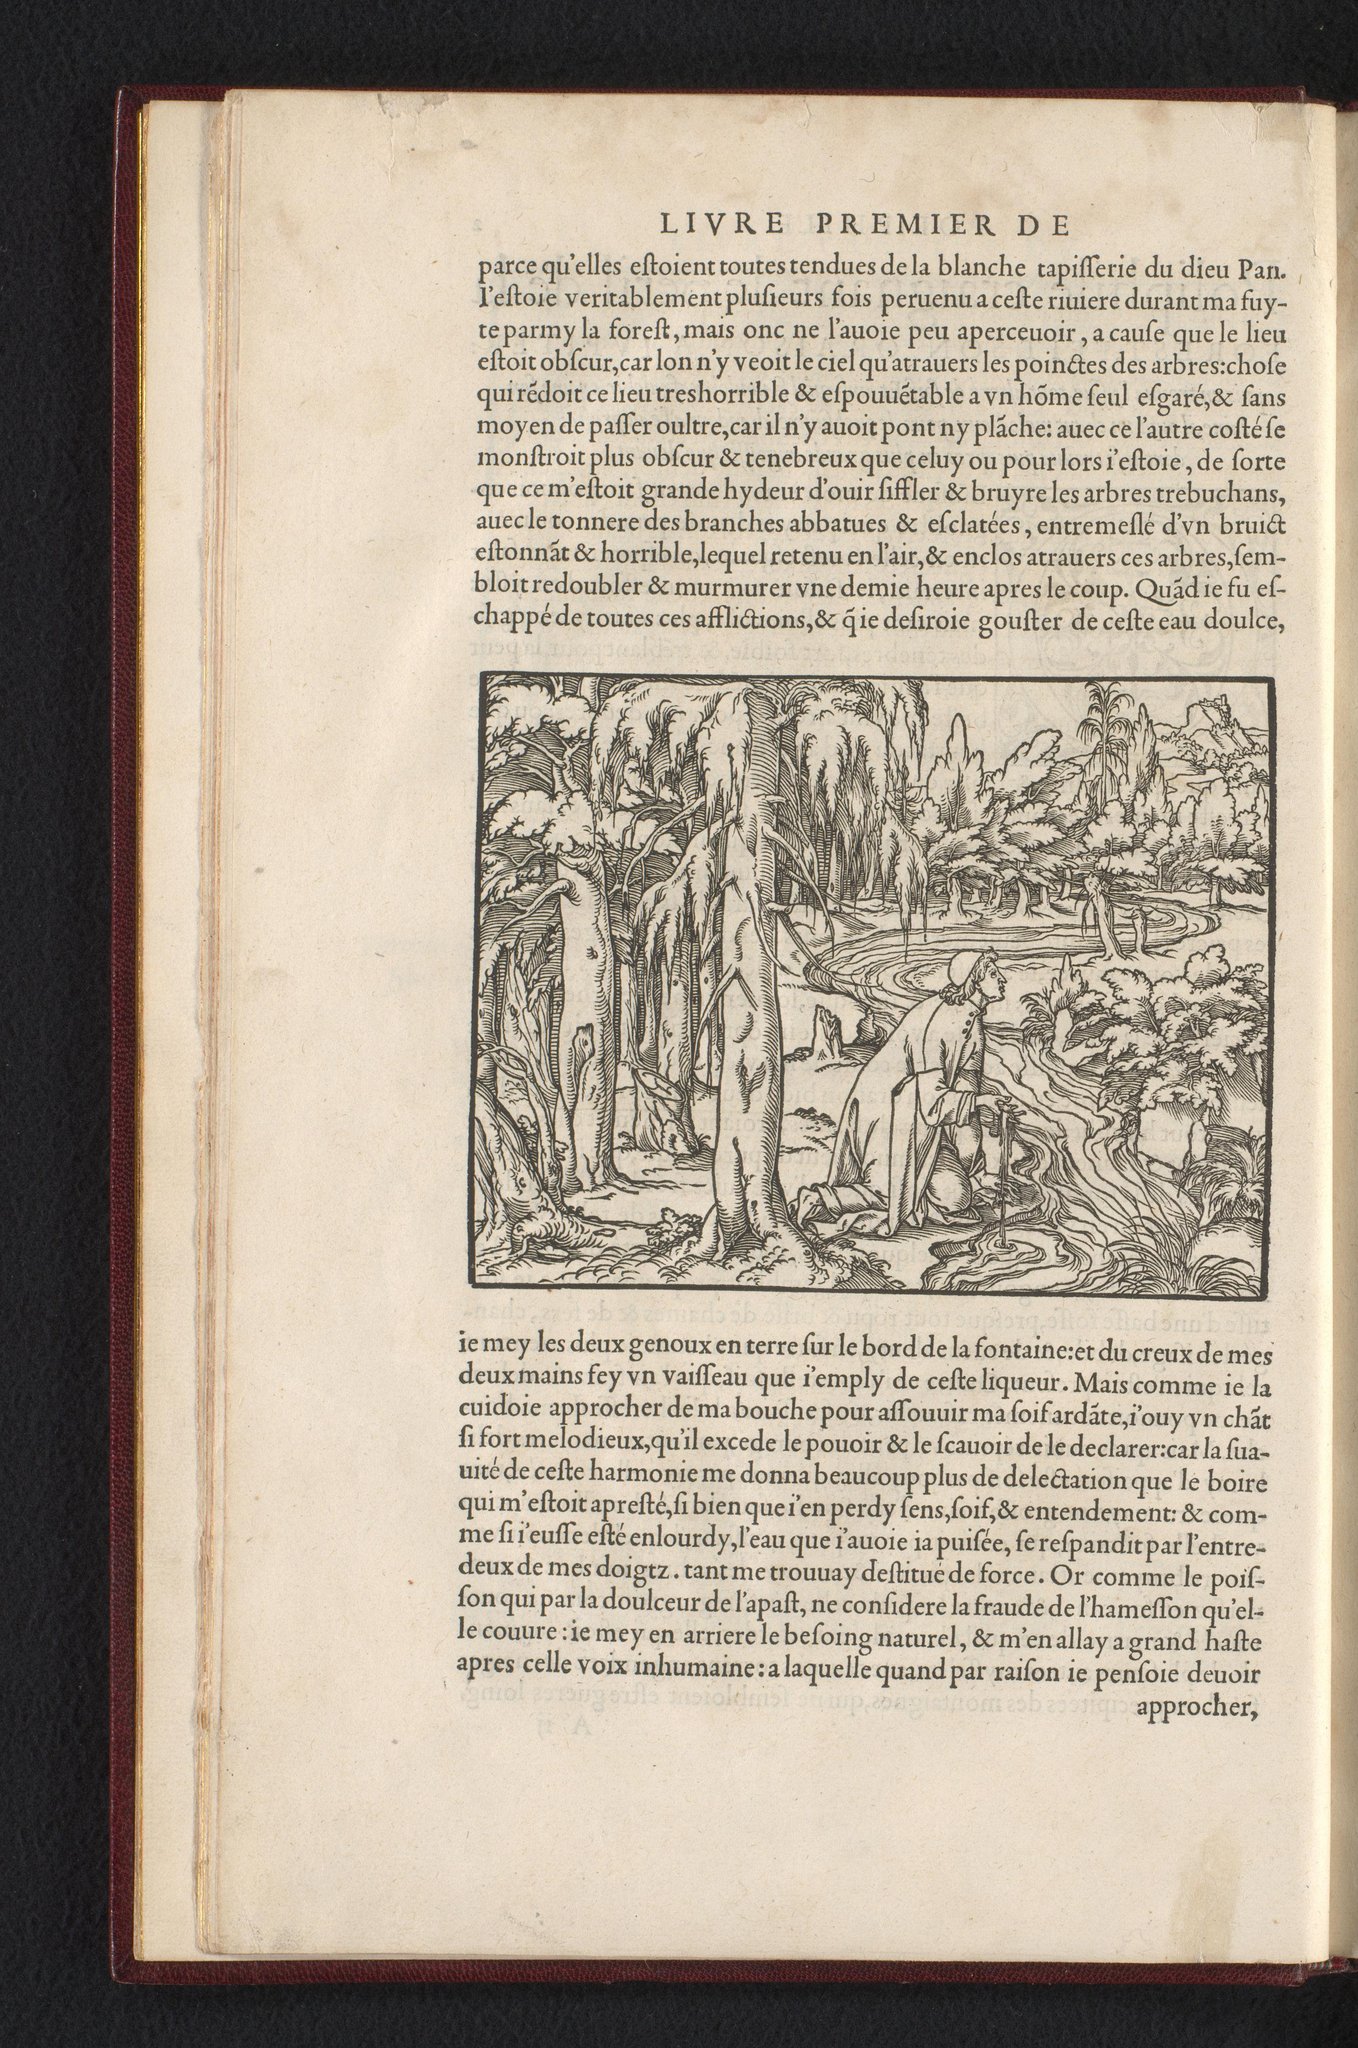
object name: print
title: Poliphilo wil uit de rivier drinken en hoort gezang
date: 1546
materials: paper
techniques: letterpress printing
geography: paris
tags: river, (scenes from) specific works of literature: colonna, hypnerotomachia poliphili, drinking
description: Prent uit: Colonna, Francesco. Hypnerotomachie ou discours du songe de Poliphile, deduisant comme amour le combat a l'occasion de Polia. Parijs: Jacques Kerver, 1546, verso fol. 2.